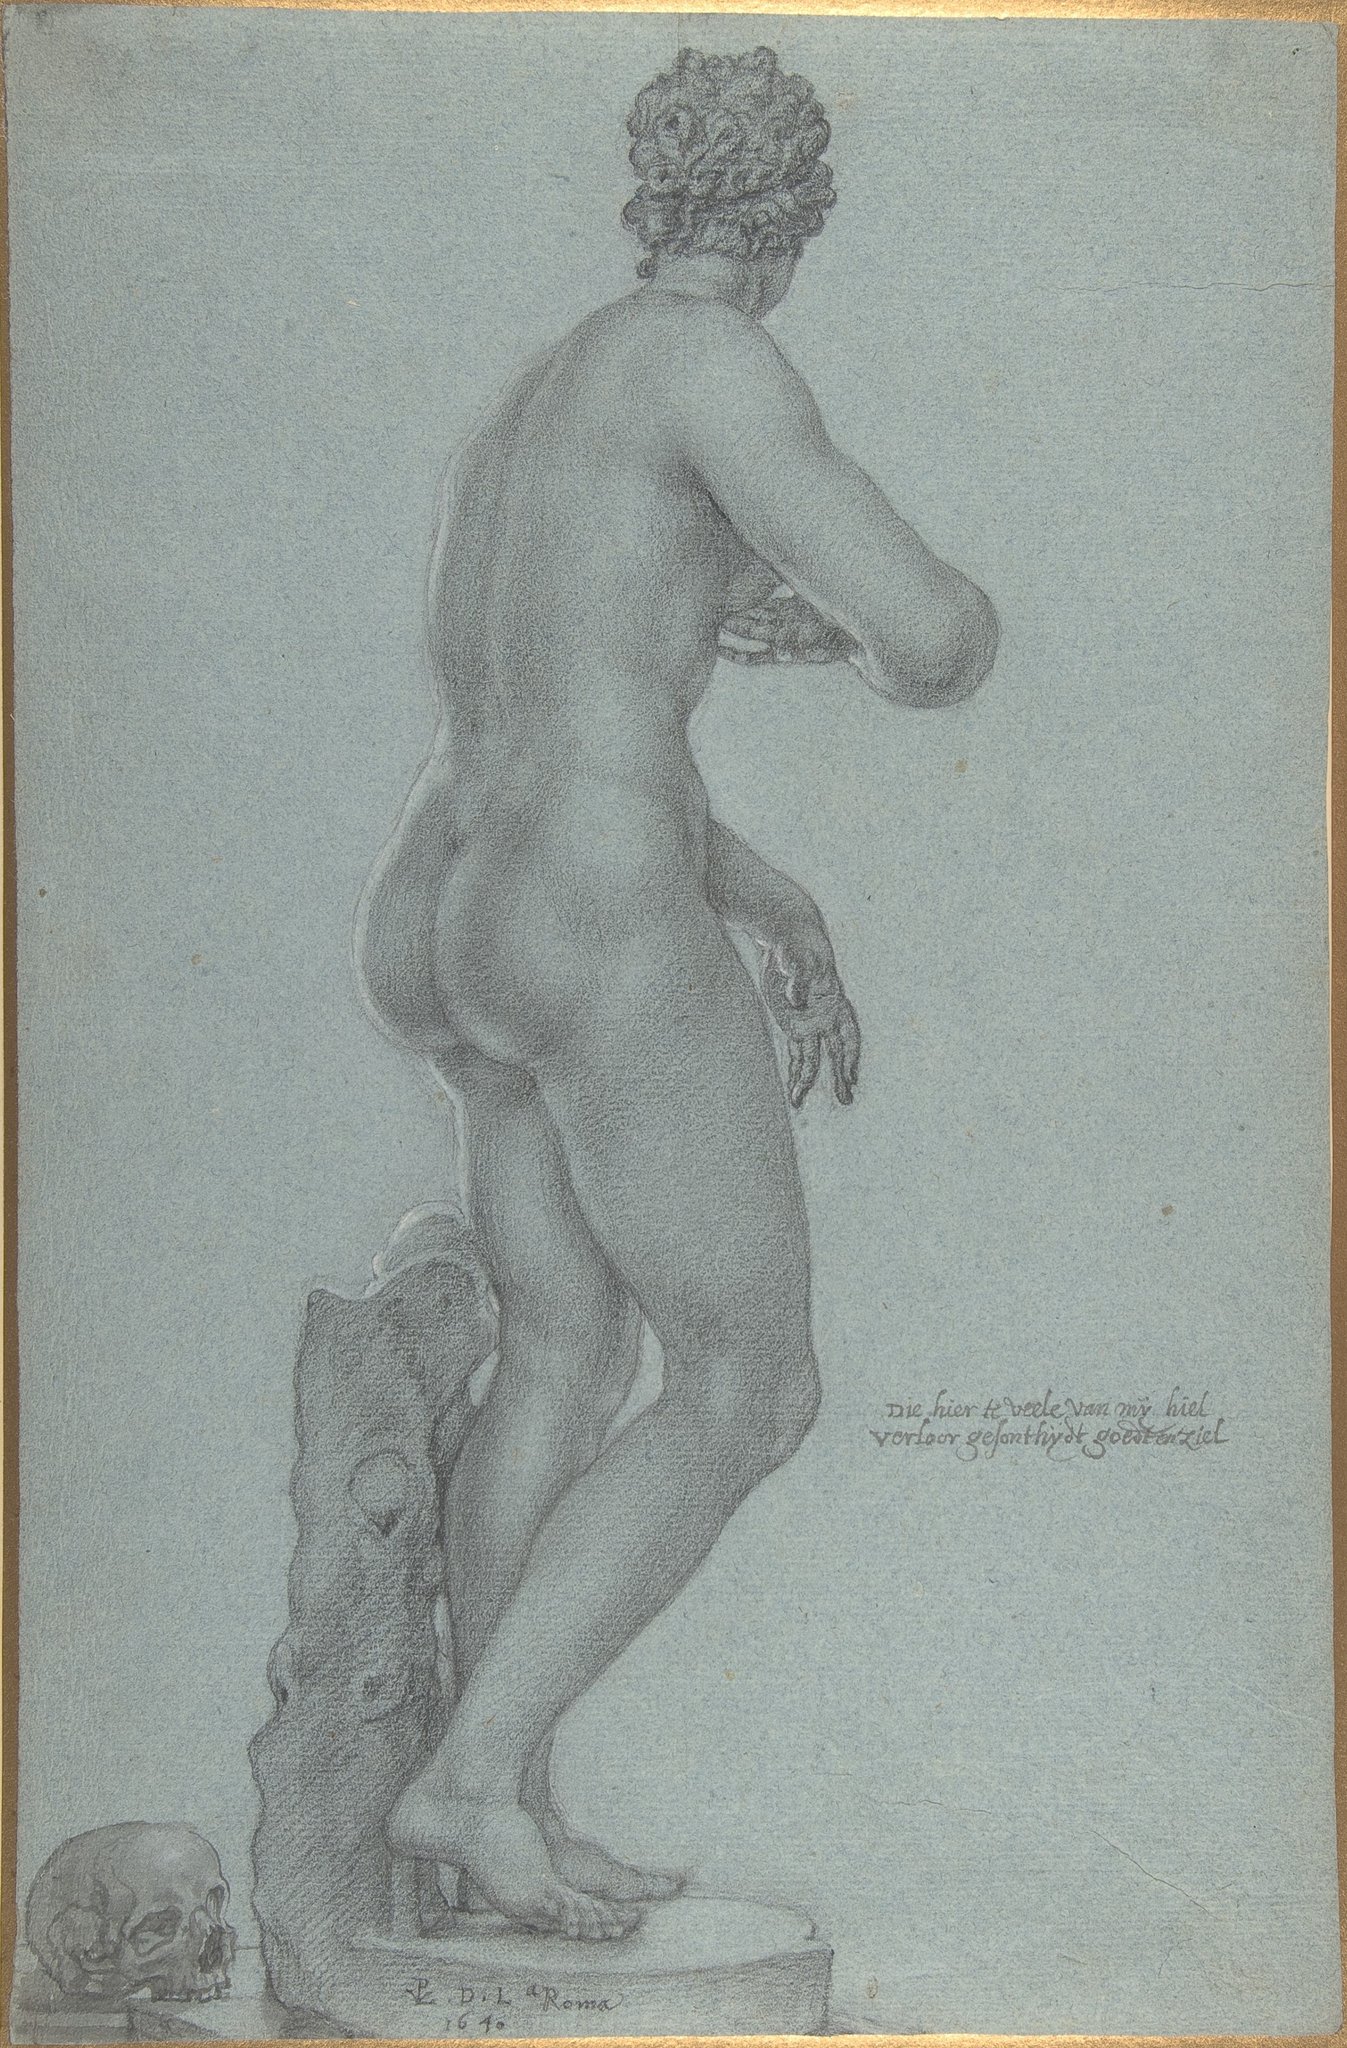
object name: drawing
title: Venus de' Medici; view from the back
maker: peter van lint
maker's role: artist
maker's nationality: flemish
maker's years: 1609-1690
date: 1640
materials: chalk, paper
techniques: brush, heightening, wash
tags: skulls,venus